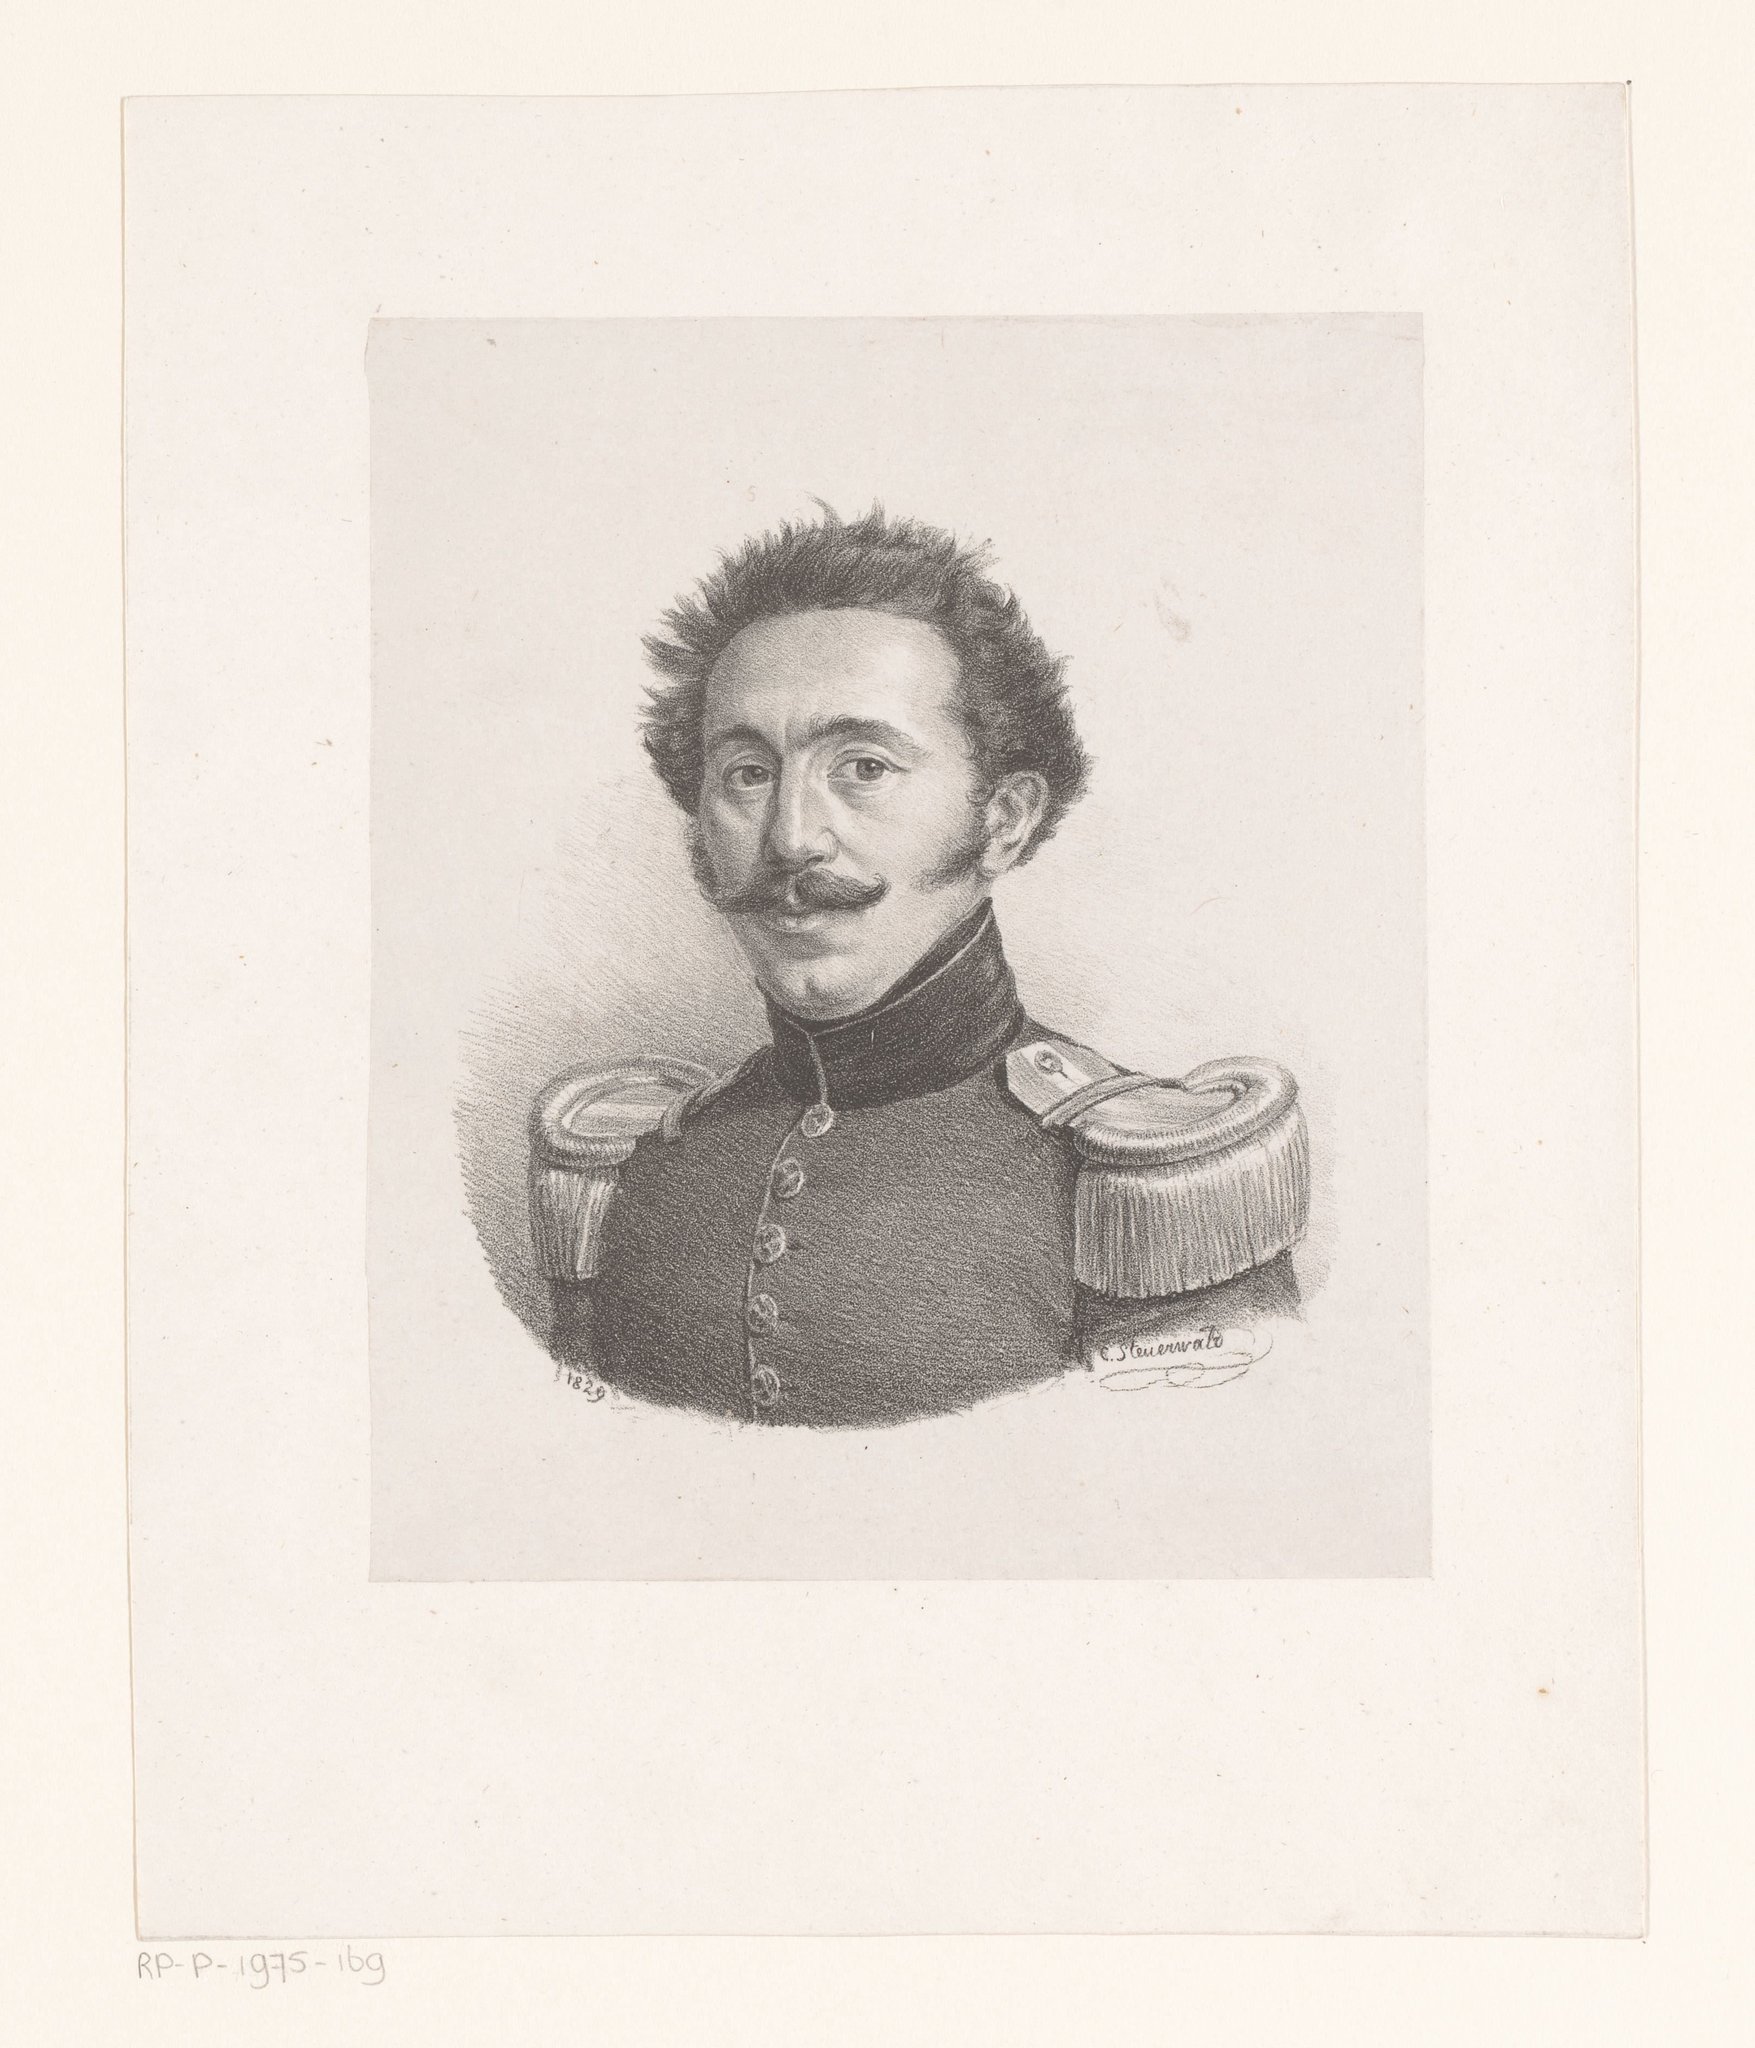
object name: print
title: Portret van Pierre François Louis Rigano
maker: christian heinrich gottlieb steuerwald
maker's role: draughtsman, print maker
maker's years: 1802-1874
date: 1829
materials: paper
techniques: lithograph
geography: dordrecht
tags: historical persons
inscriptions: collector's mark: Lugt 2228, inscription: ‘4a / 18-9-'75’